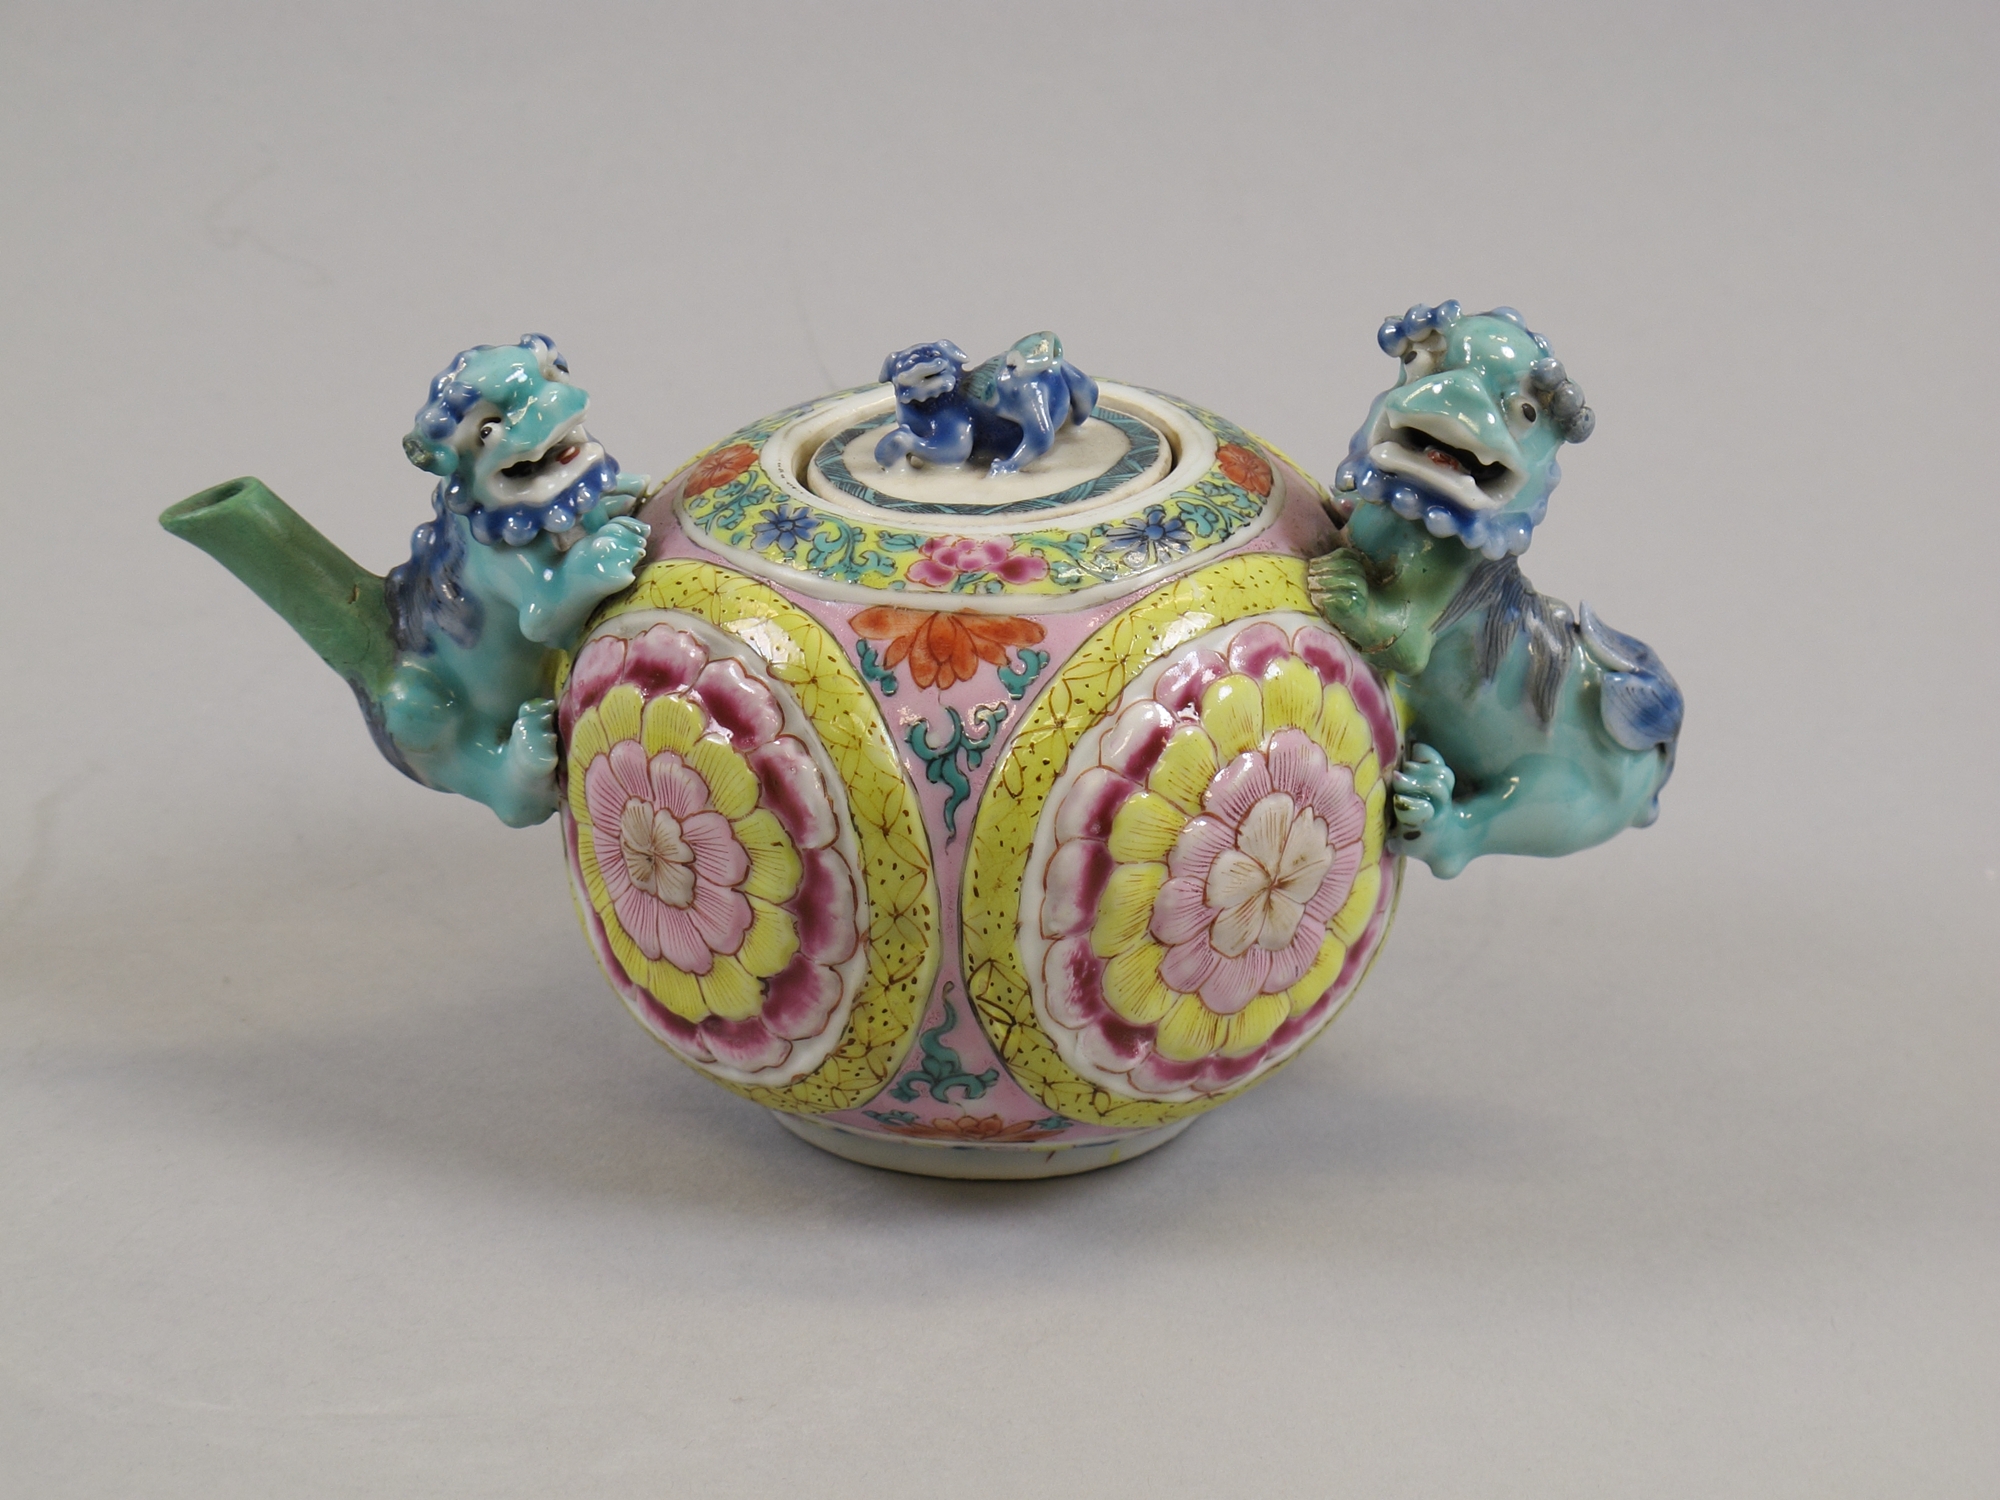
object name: teapot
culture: chinese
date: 1644-1911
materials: enamel, porcelain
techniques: overglaze, painting, polychrome, relief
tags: lions